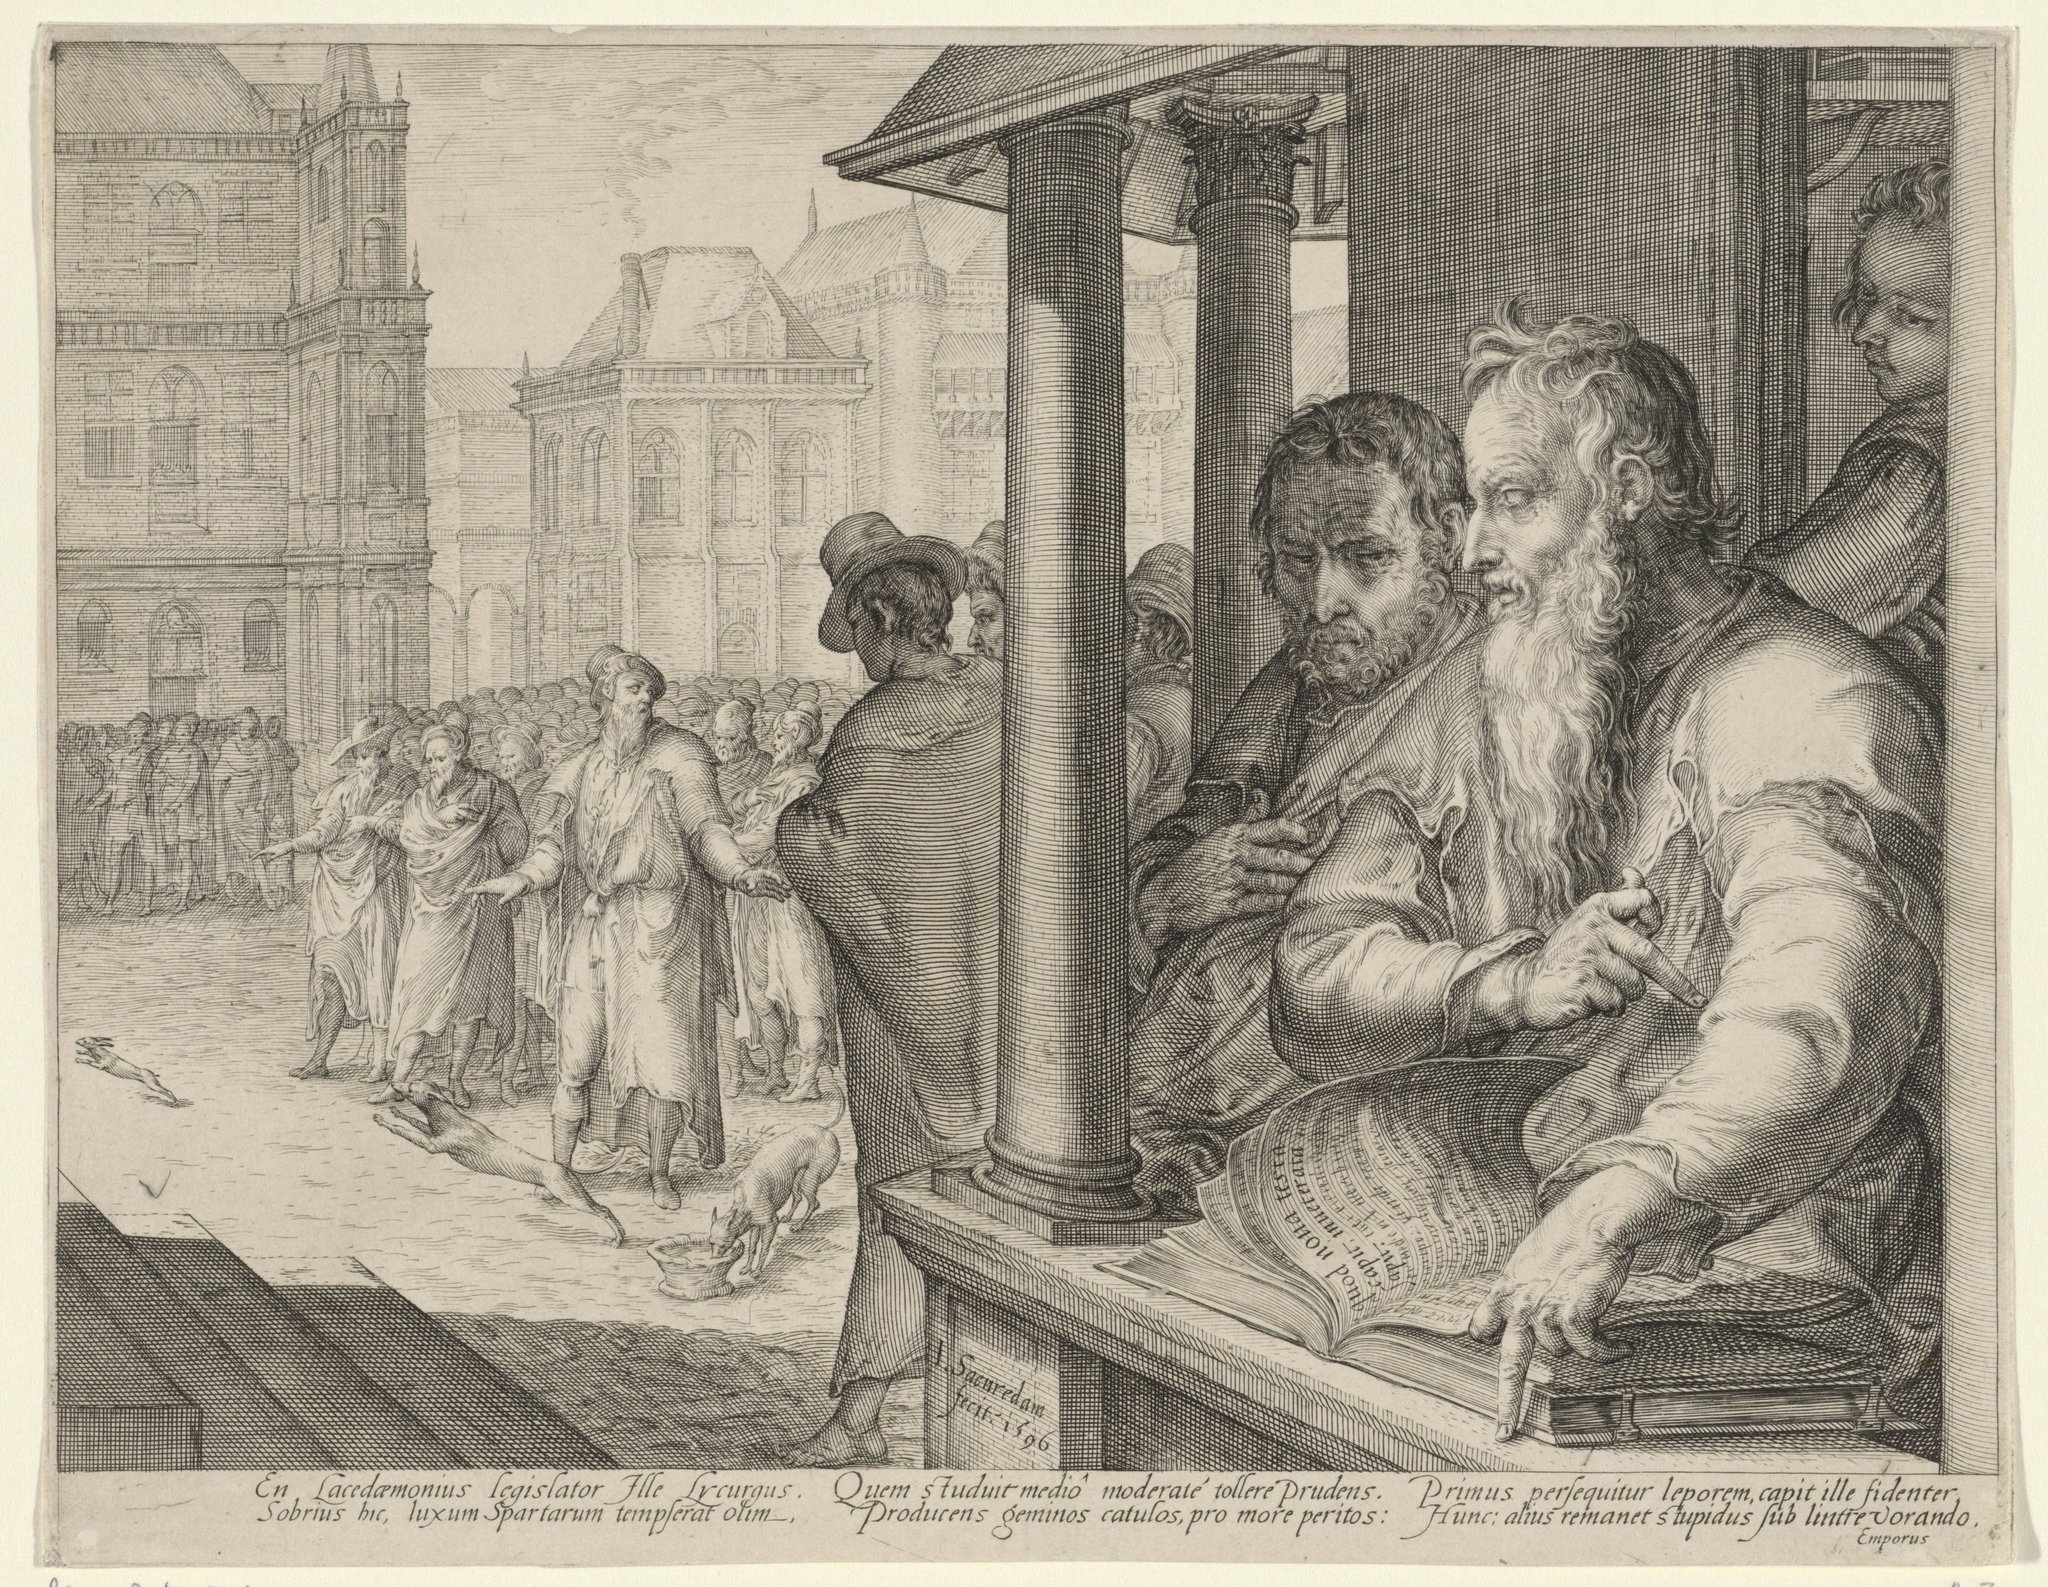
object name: print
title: Lycurgus houdt een verhandeling over de voordelen van opvoeding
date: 1596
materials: paper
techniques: engraving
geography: assendelft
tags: lycurgus, the spartan, demonstrates the importance of good education by comparing the behaviour of two dogs: one eats from his dish, the other chases a hare, training of dogs, dog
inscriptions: date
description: Lycurgus, de befaamde Spartaanse wetgever, rechts op de voorgrond. Hij leest uit een boek. Op de achtergrond een marktplein met toeschouwers. Twee honden worden op het marktplein losgelaten. De ene hond eet uit een bak voedsel dat voor hen is klaargezet, de andere hond rent een losgelaten haas achterna. De voorstelling verbeeldt een parabel van Lycurgus. De wetgever wou het belang van opvoeding aantonen en trainde twee honden van hetzelfde nest op een andere manier. De ene hond moest jagen voor zijn eten, terwijl de andere hond altijd werd gevoederd. Als hij de twee honden op het forum van Sparta loslaat, gedragen de honden zich naar hun opvoeding. De parabel komt voor in Plutarchus' Moralia (3:16). De prent heeft een Latijns tekst in de marge met uitleg.